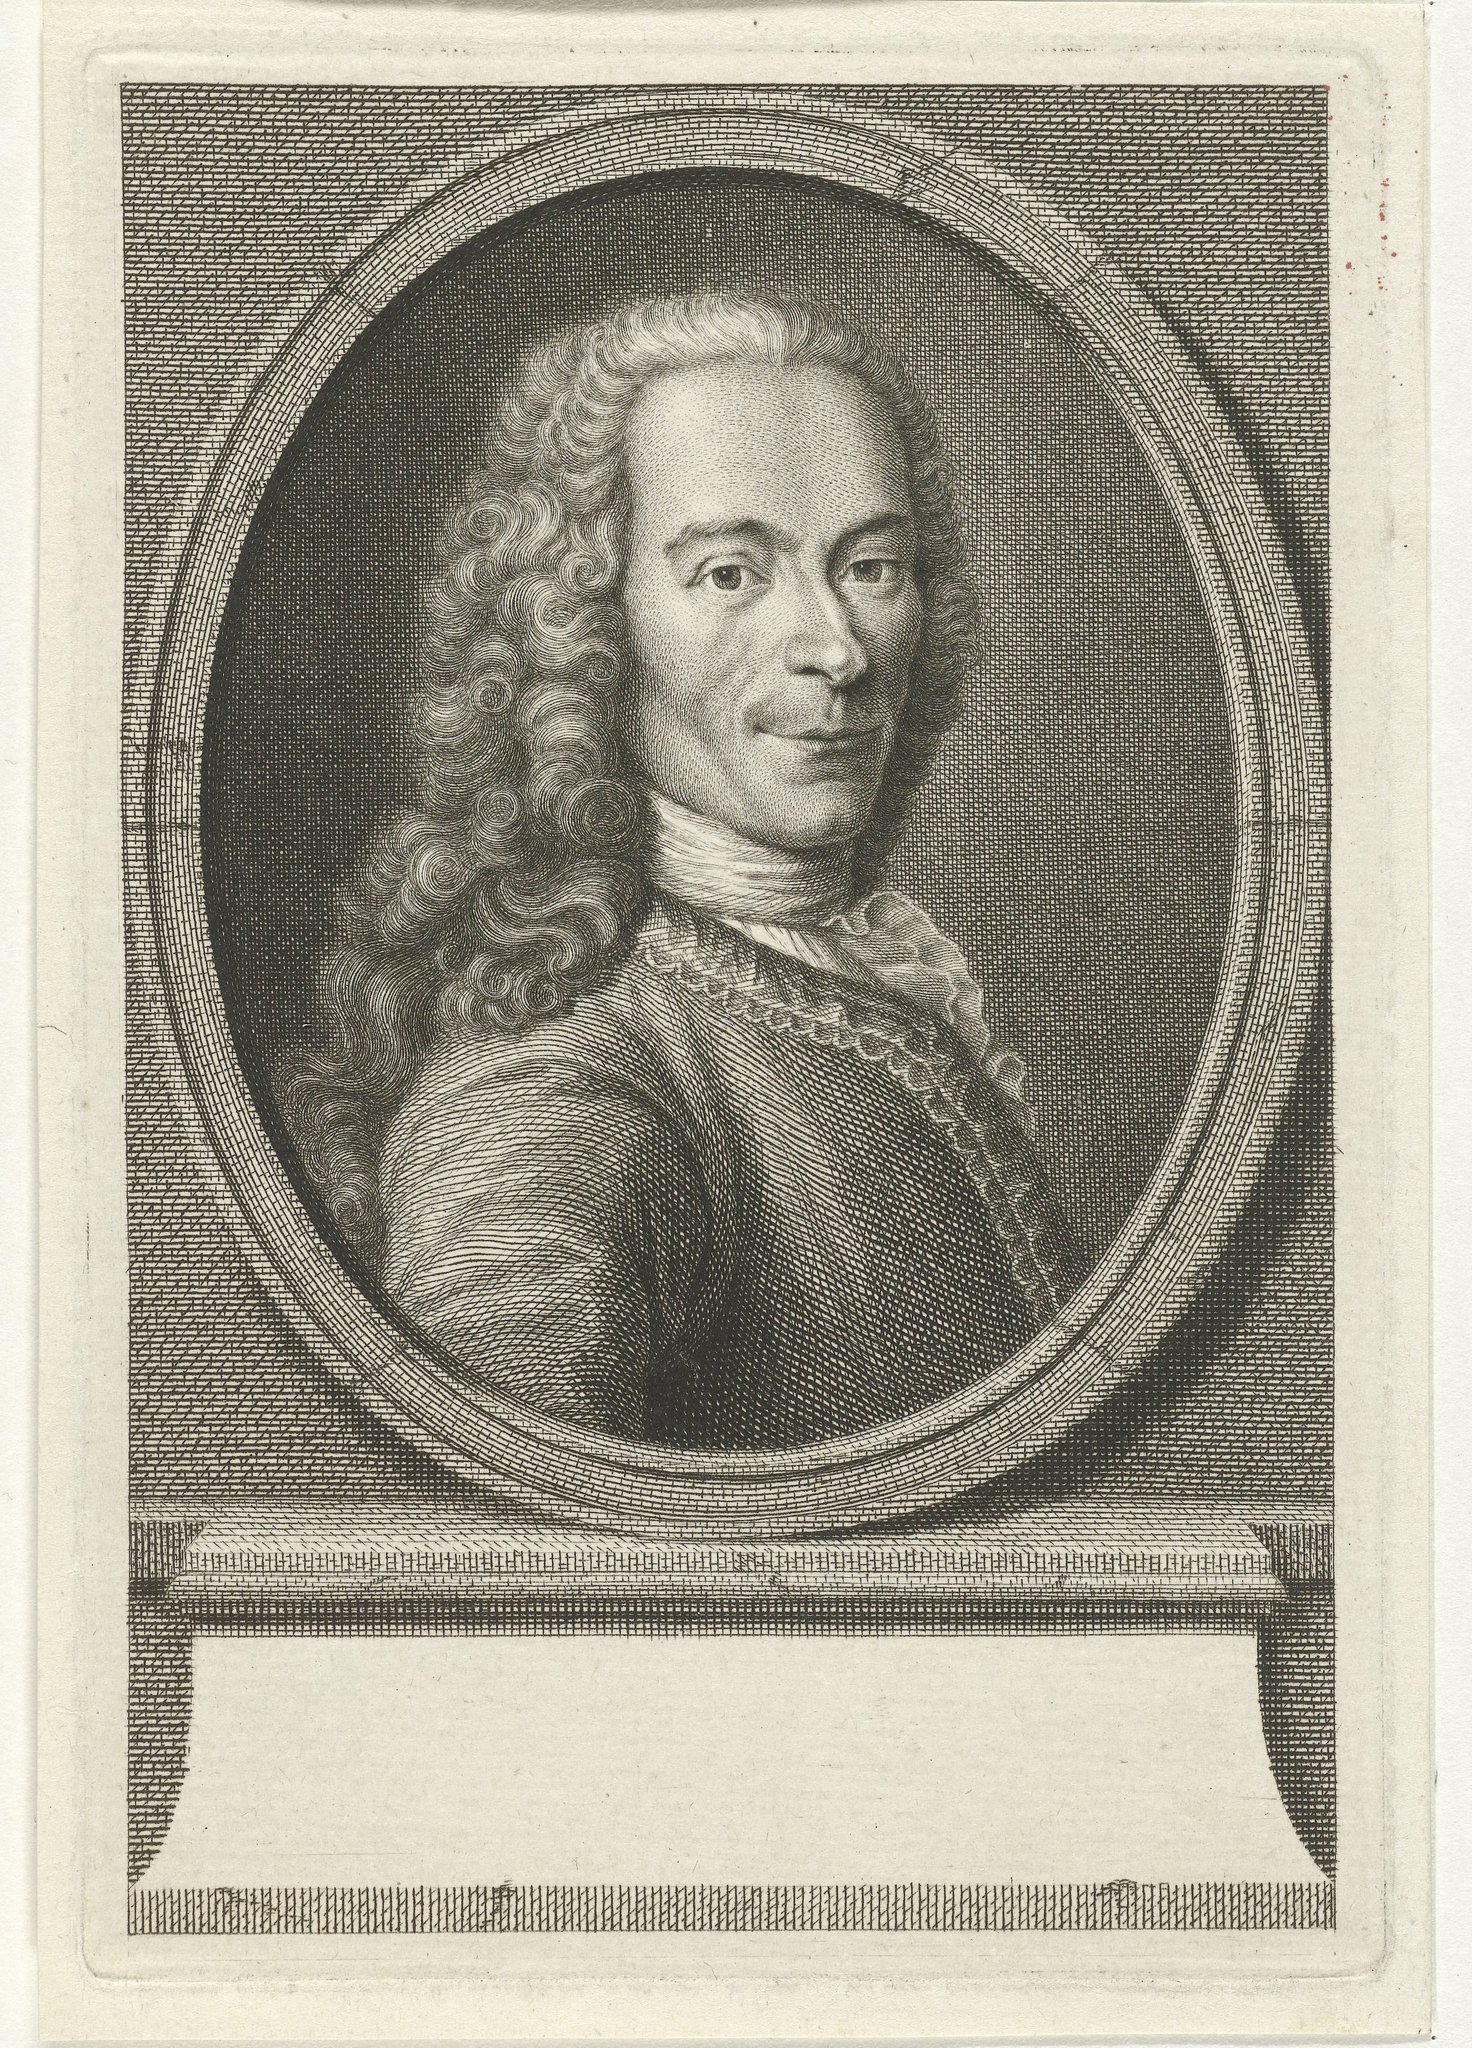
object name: print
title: Portret van Voltaire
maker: jacob folkema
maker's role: draughtsman, print maker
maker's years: 1692-1767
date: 1702-1767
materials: paper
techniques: engraving, etching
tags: paris, voltaire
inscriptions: collector's mark: Lugt 240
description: Portretbuste in ovaal naar rechts van de Franse schrijver Voltaire, blootshoofds. Het portret staat op een door de prentmaker nog te bewerken sokkel.